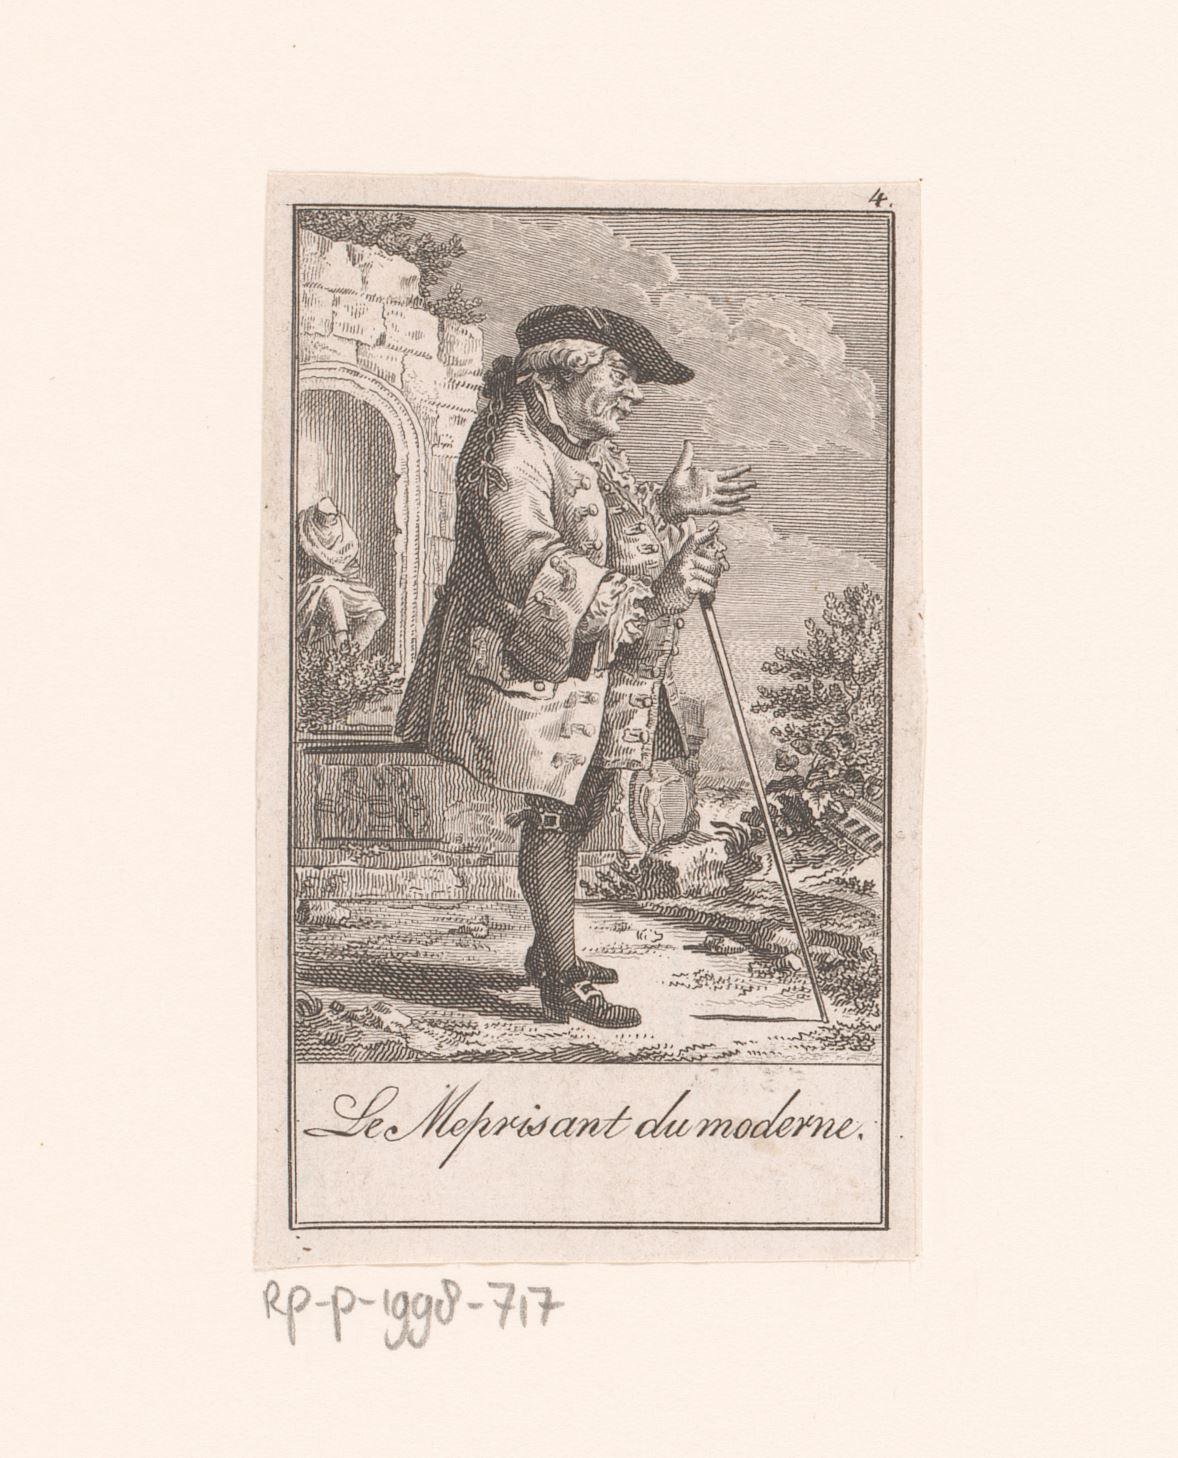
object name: print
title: Man die het moderne minacht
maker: karl heinrich grünler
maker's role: print maker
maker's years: 1761-1823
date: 1771-1823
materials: paper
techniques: etching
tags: walking-stick, staff, contempt, adult man, garden ornaments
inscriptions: collector's mark: Lugt 2228